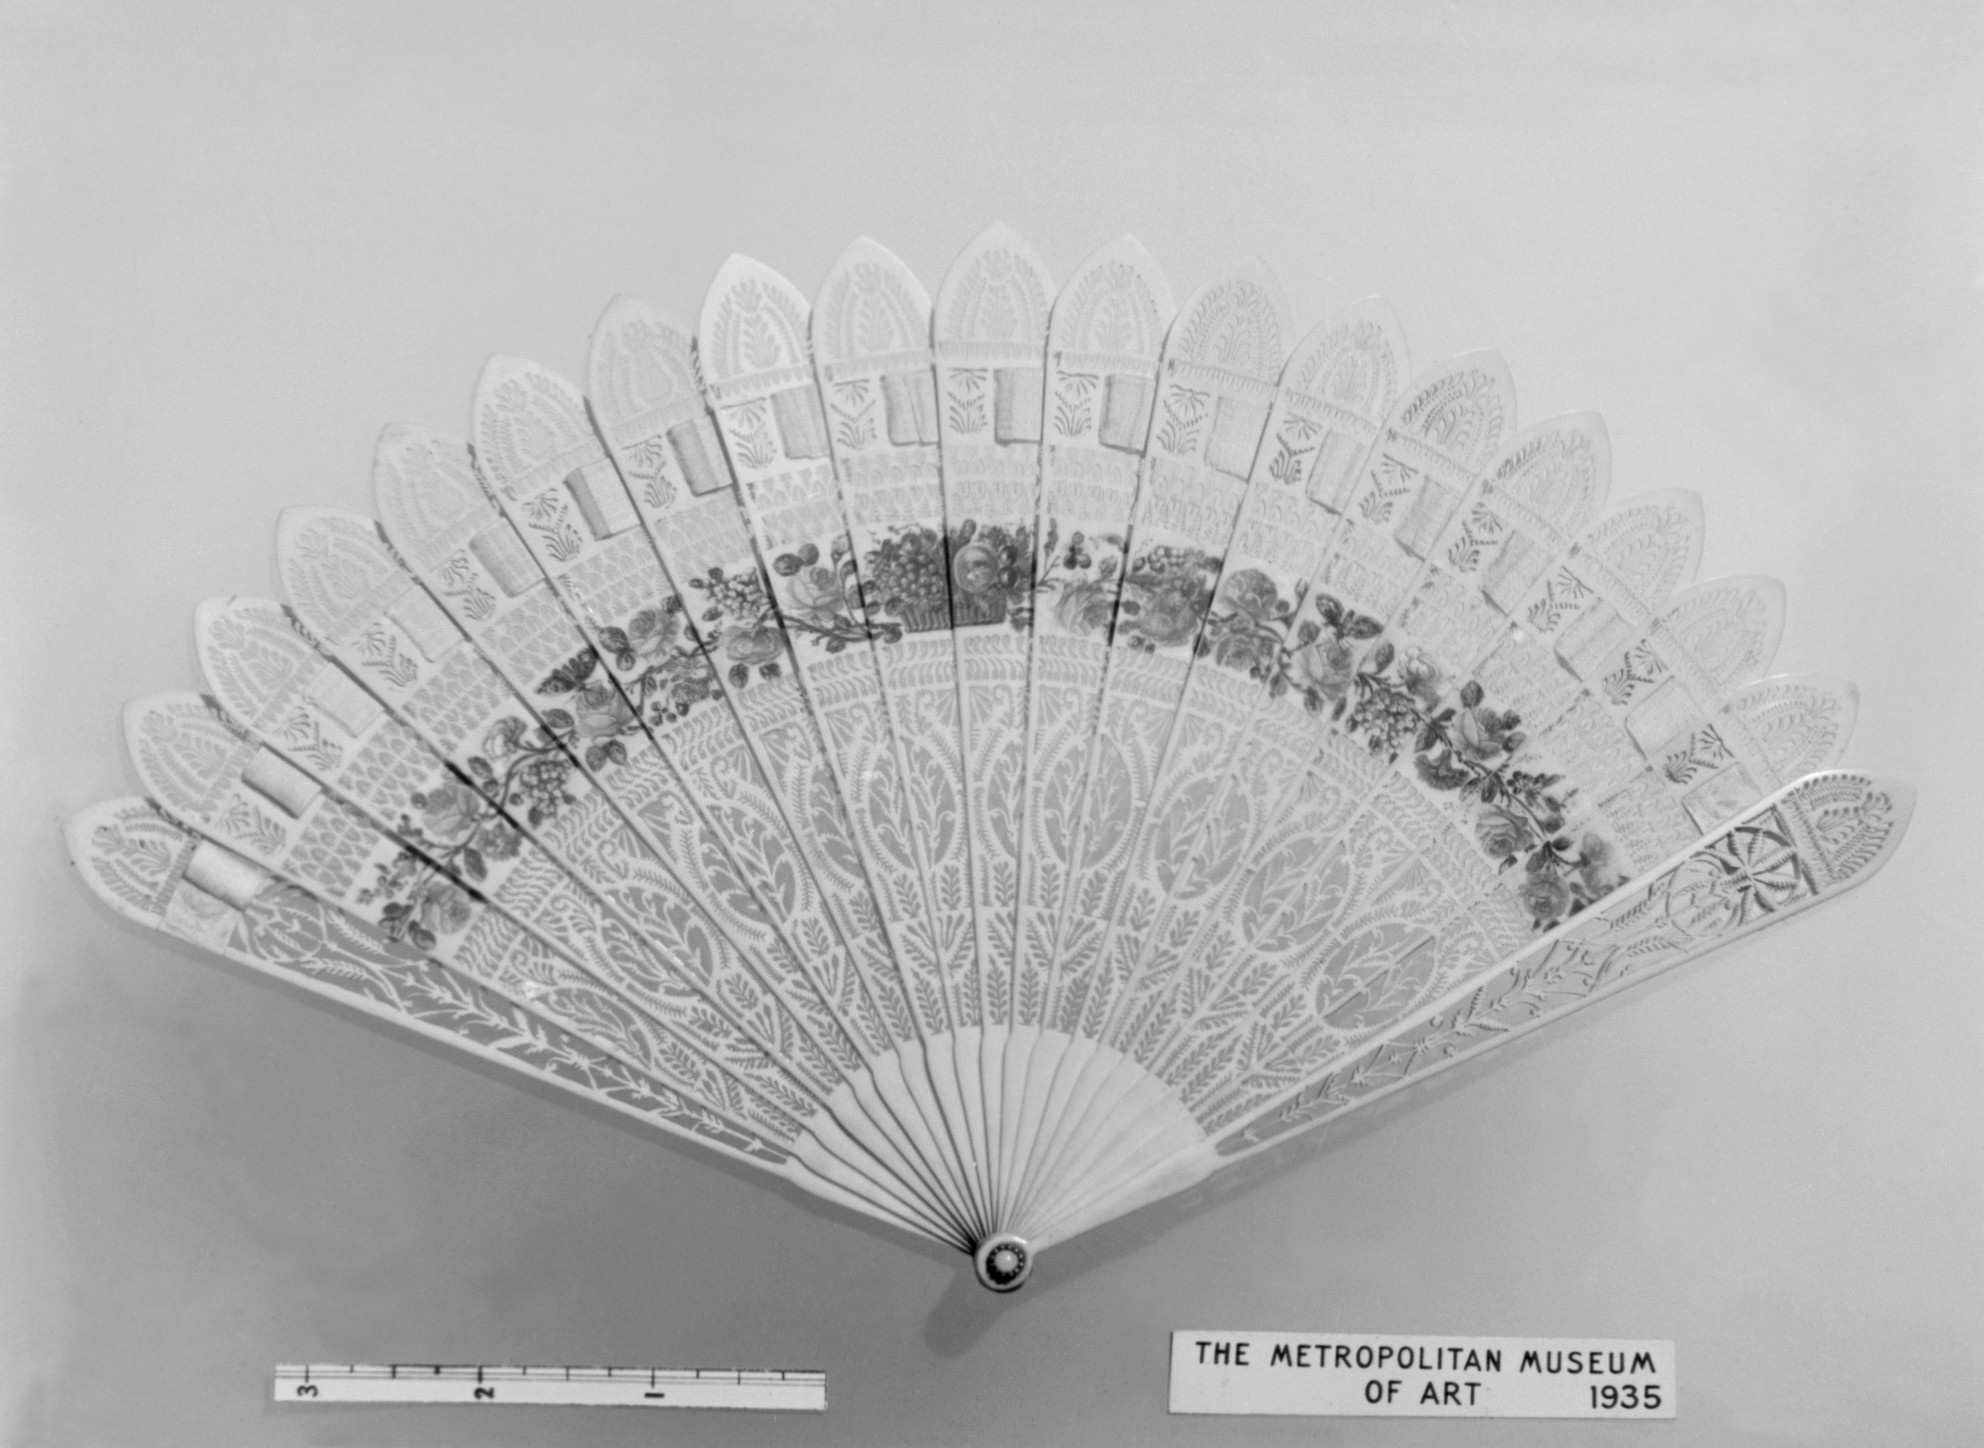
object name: fan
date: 1801-1850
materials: gilt, ivory